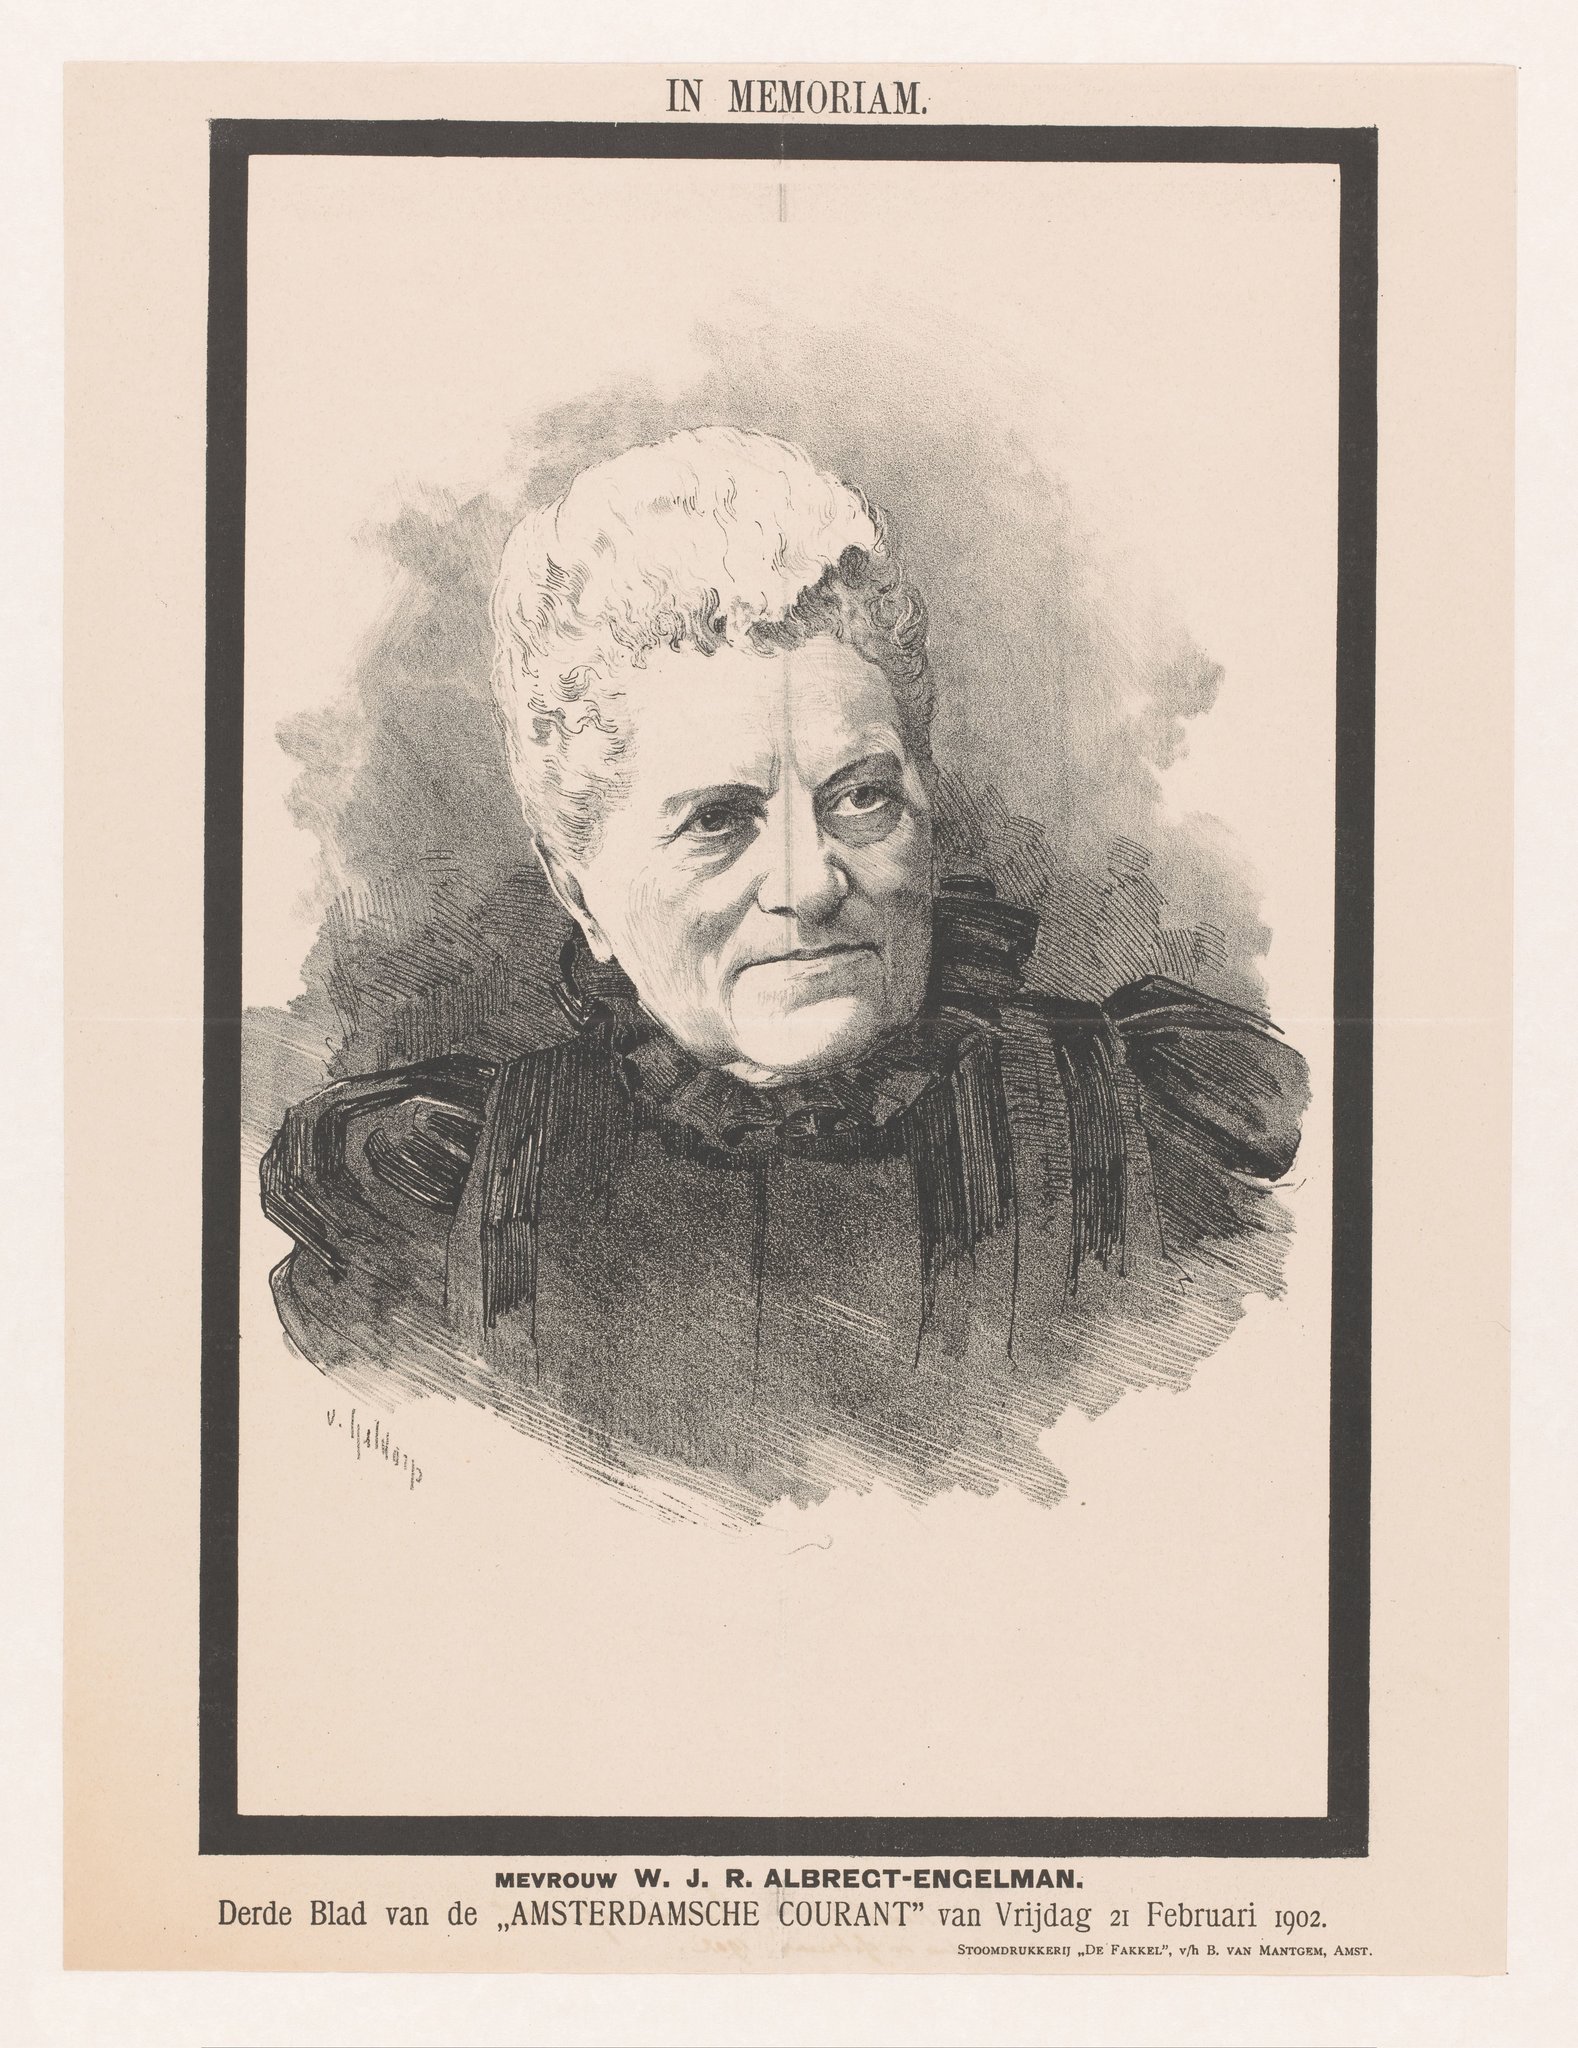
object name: print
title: Soldaat en zittende man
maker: joannes bemme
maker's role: print maker, printer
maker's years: 1775-1841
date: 1809-1841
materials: paper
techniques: lithograph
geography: netherlands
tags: private soldier, hacking and thrusting weapons: sword, sitting on the ground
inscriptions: collector's mark: Lugt 2228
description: De soldaat, op de rug gezien, staat licht voorover gebogen. In zijn rechterhand heeft hij een speer, met zijn linkerarm wijst hij naar links. Hij draagt een zwaard aan zijn riem. Onder hem ligt een man op de grond. Hij kijkt op naar de soldaat en wijst een andere kant op.